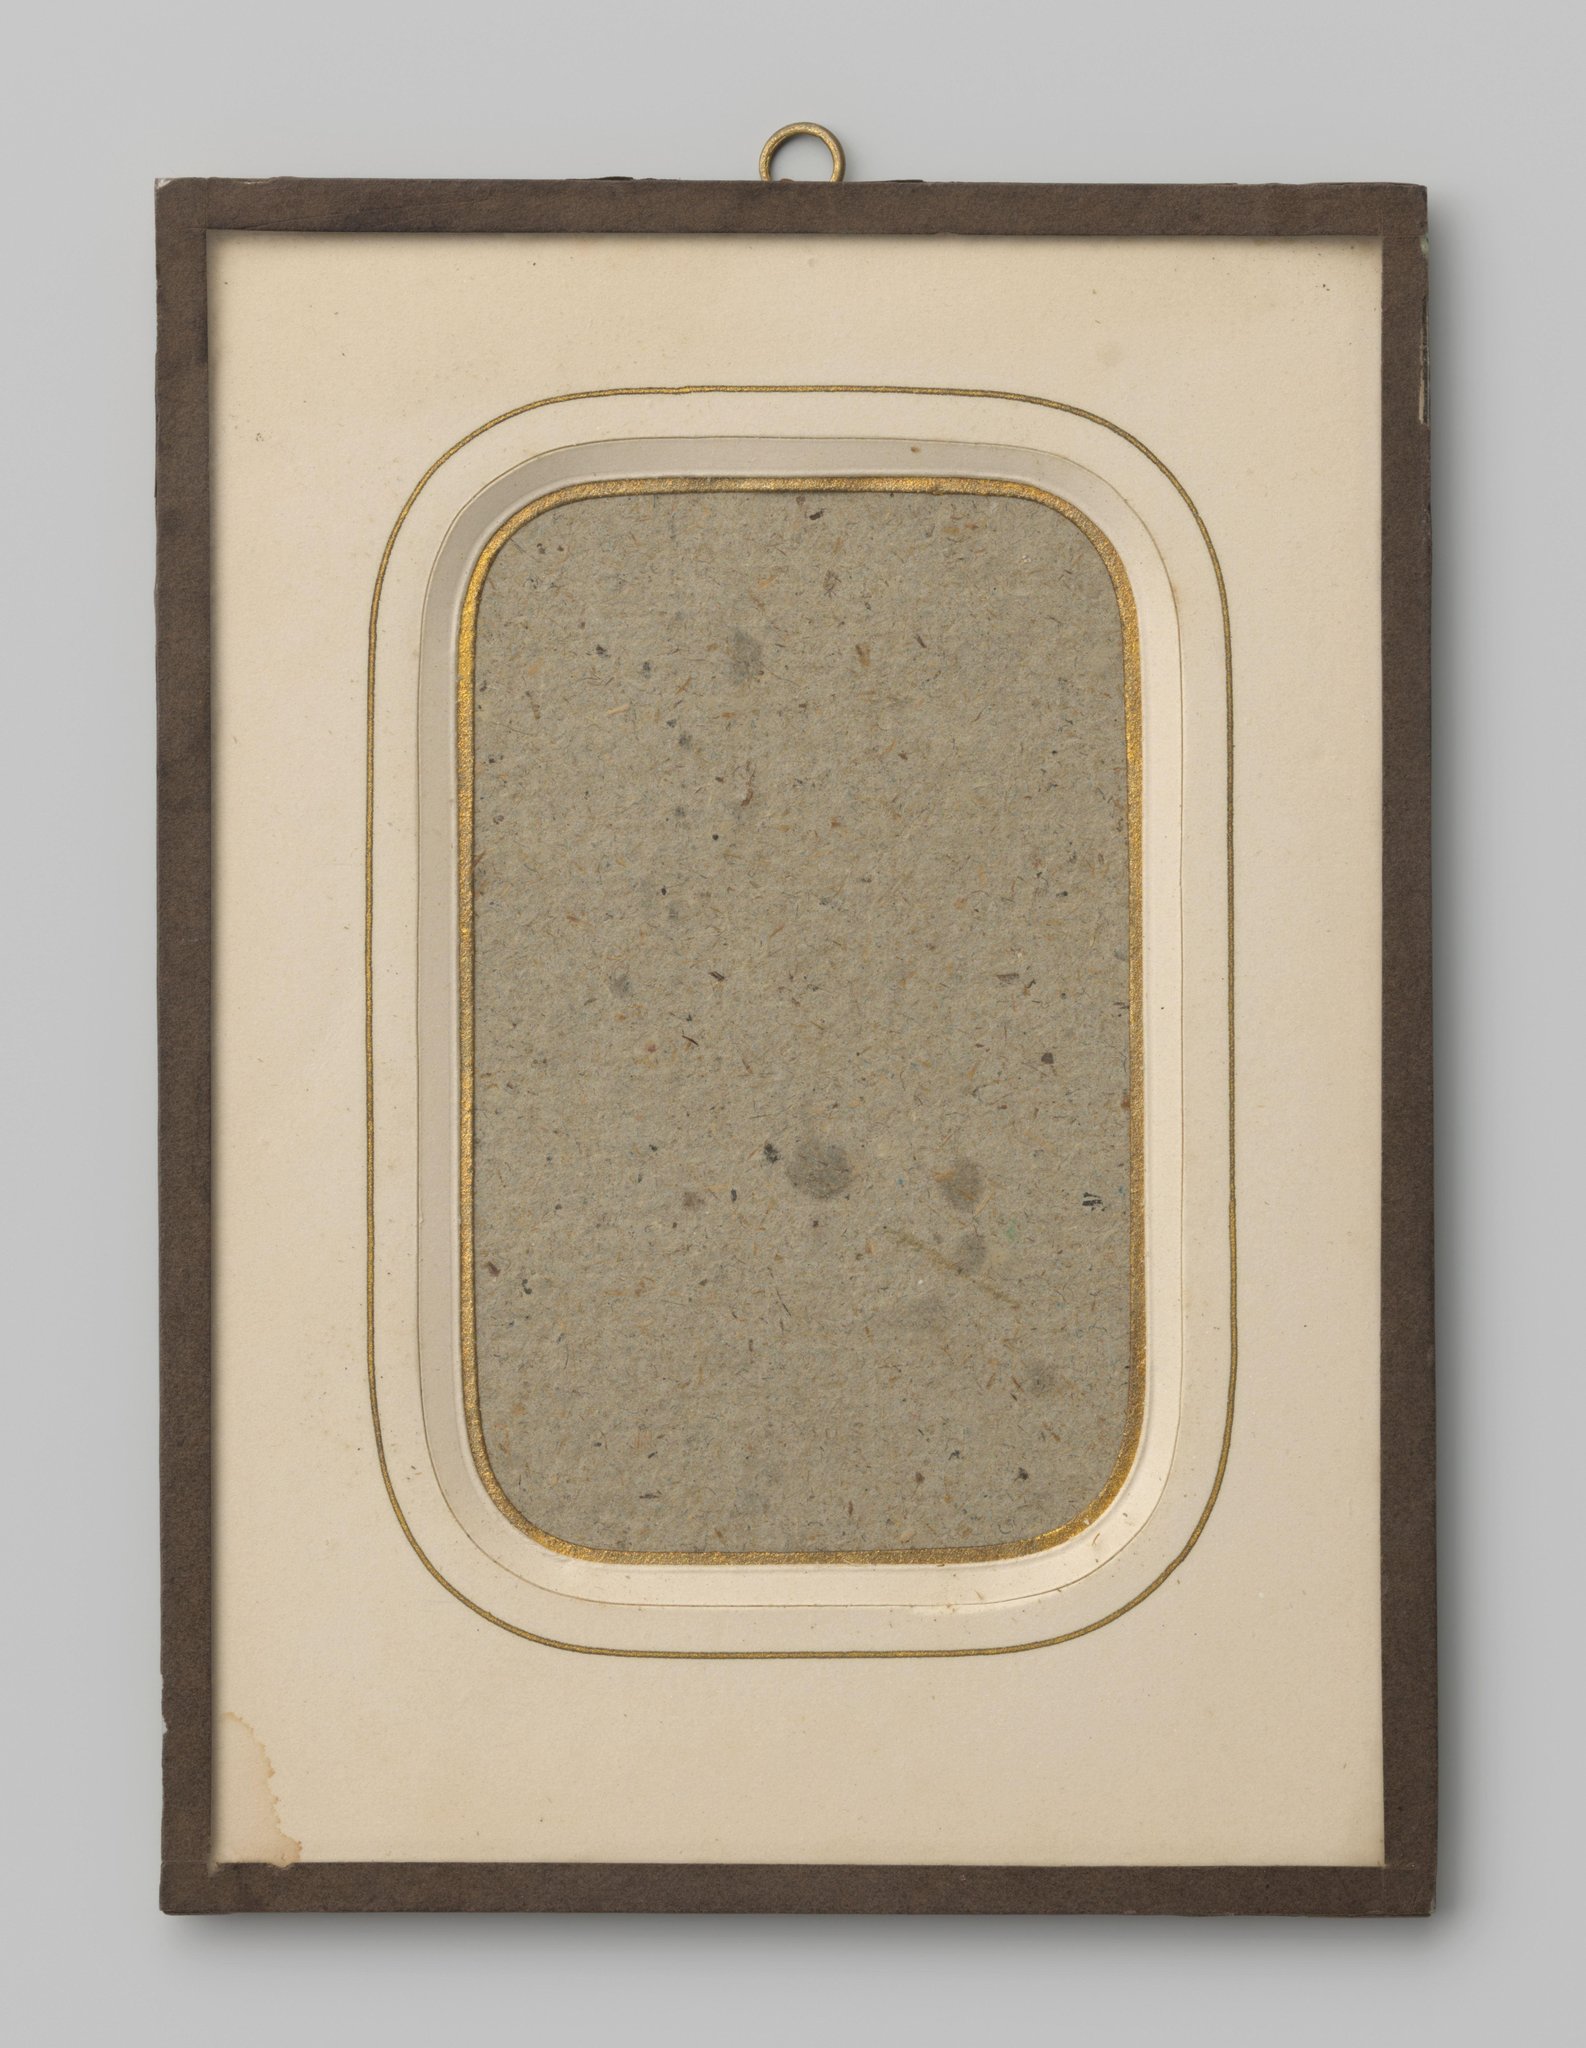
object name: frame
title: Lijst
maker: Anonymous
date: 1880-1900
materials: cardboard, glass